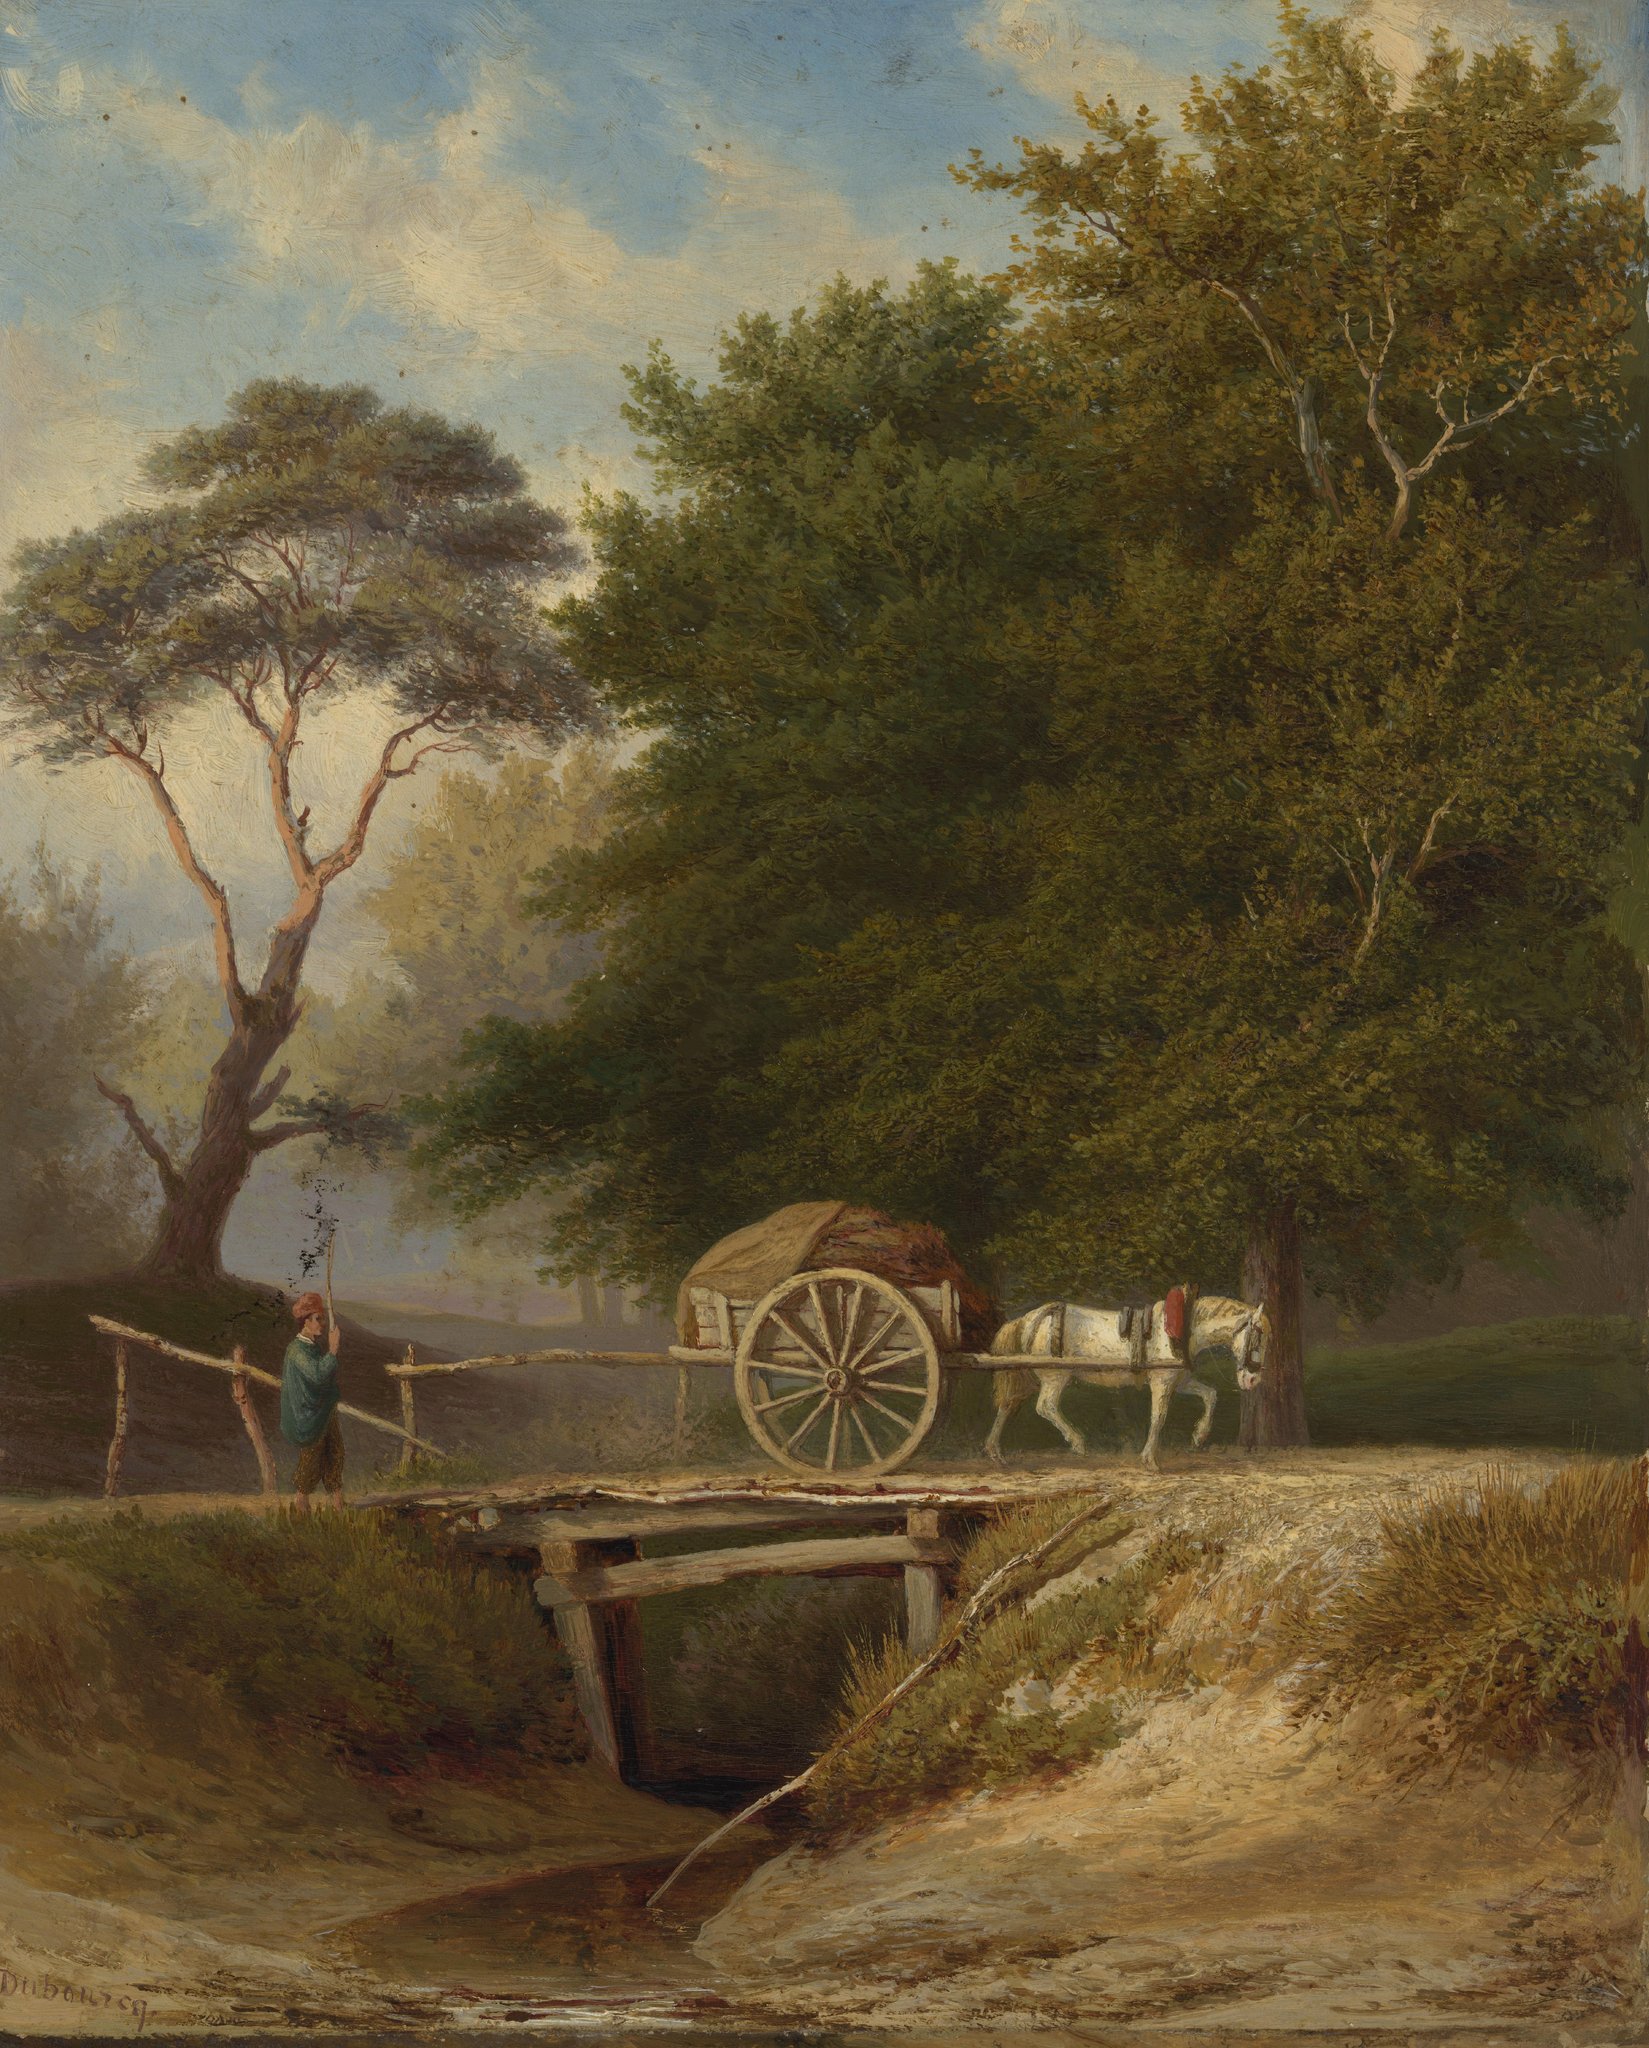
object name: painting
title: Landschap met brug te Wolfheze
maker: pierre louis dubourcq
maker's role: draughtsman, painter, print maker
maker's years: 1815-1873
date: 1840-1845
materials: oil, paint, panel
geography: fussen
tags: wolfheze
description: Over een houten brug in een bos rijdt een kar getrokken door een wit paard. De lading is half bedekt met een doek. Links staat een jonge vrouw in blauwe kleding met rode hoofddoek, met haar rug naar de kar.